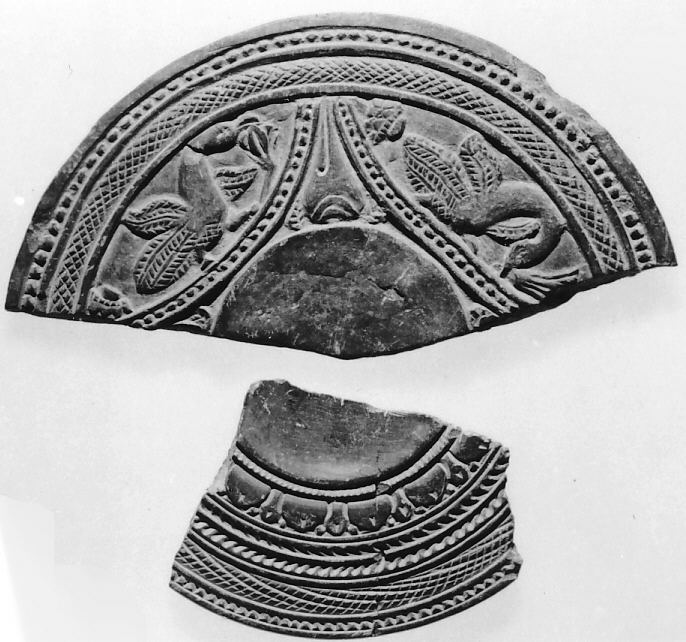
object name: cosmetic mixing palette fragment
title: Fragment of a Cosmetic Mixing Palette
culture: gandhara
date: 301-500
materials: stone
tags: birds,gandhara